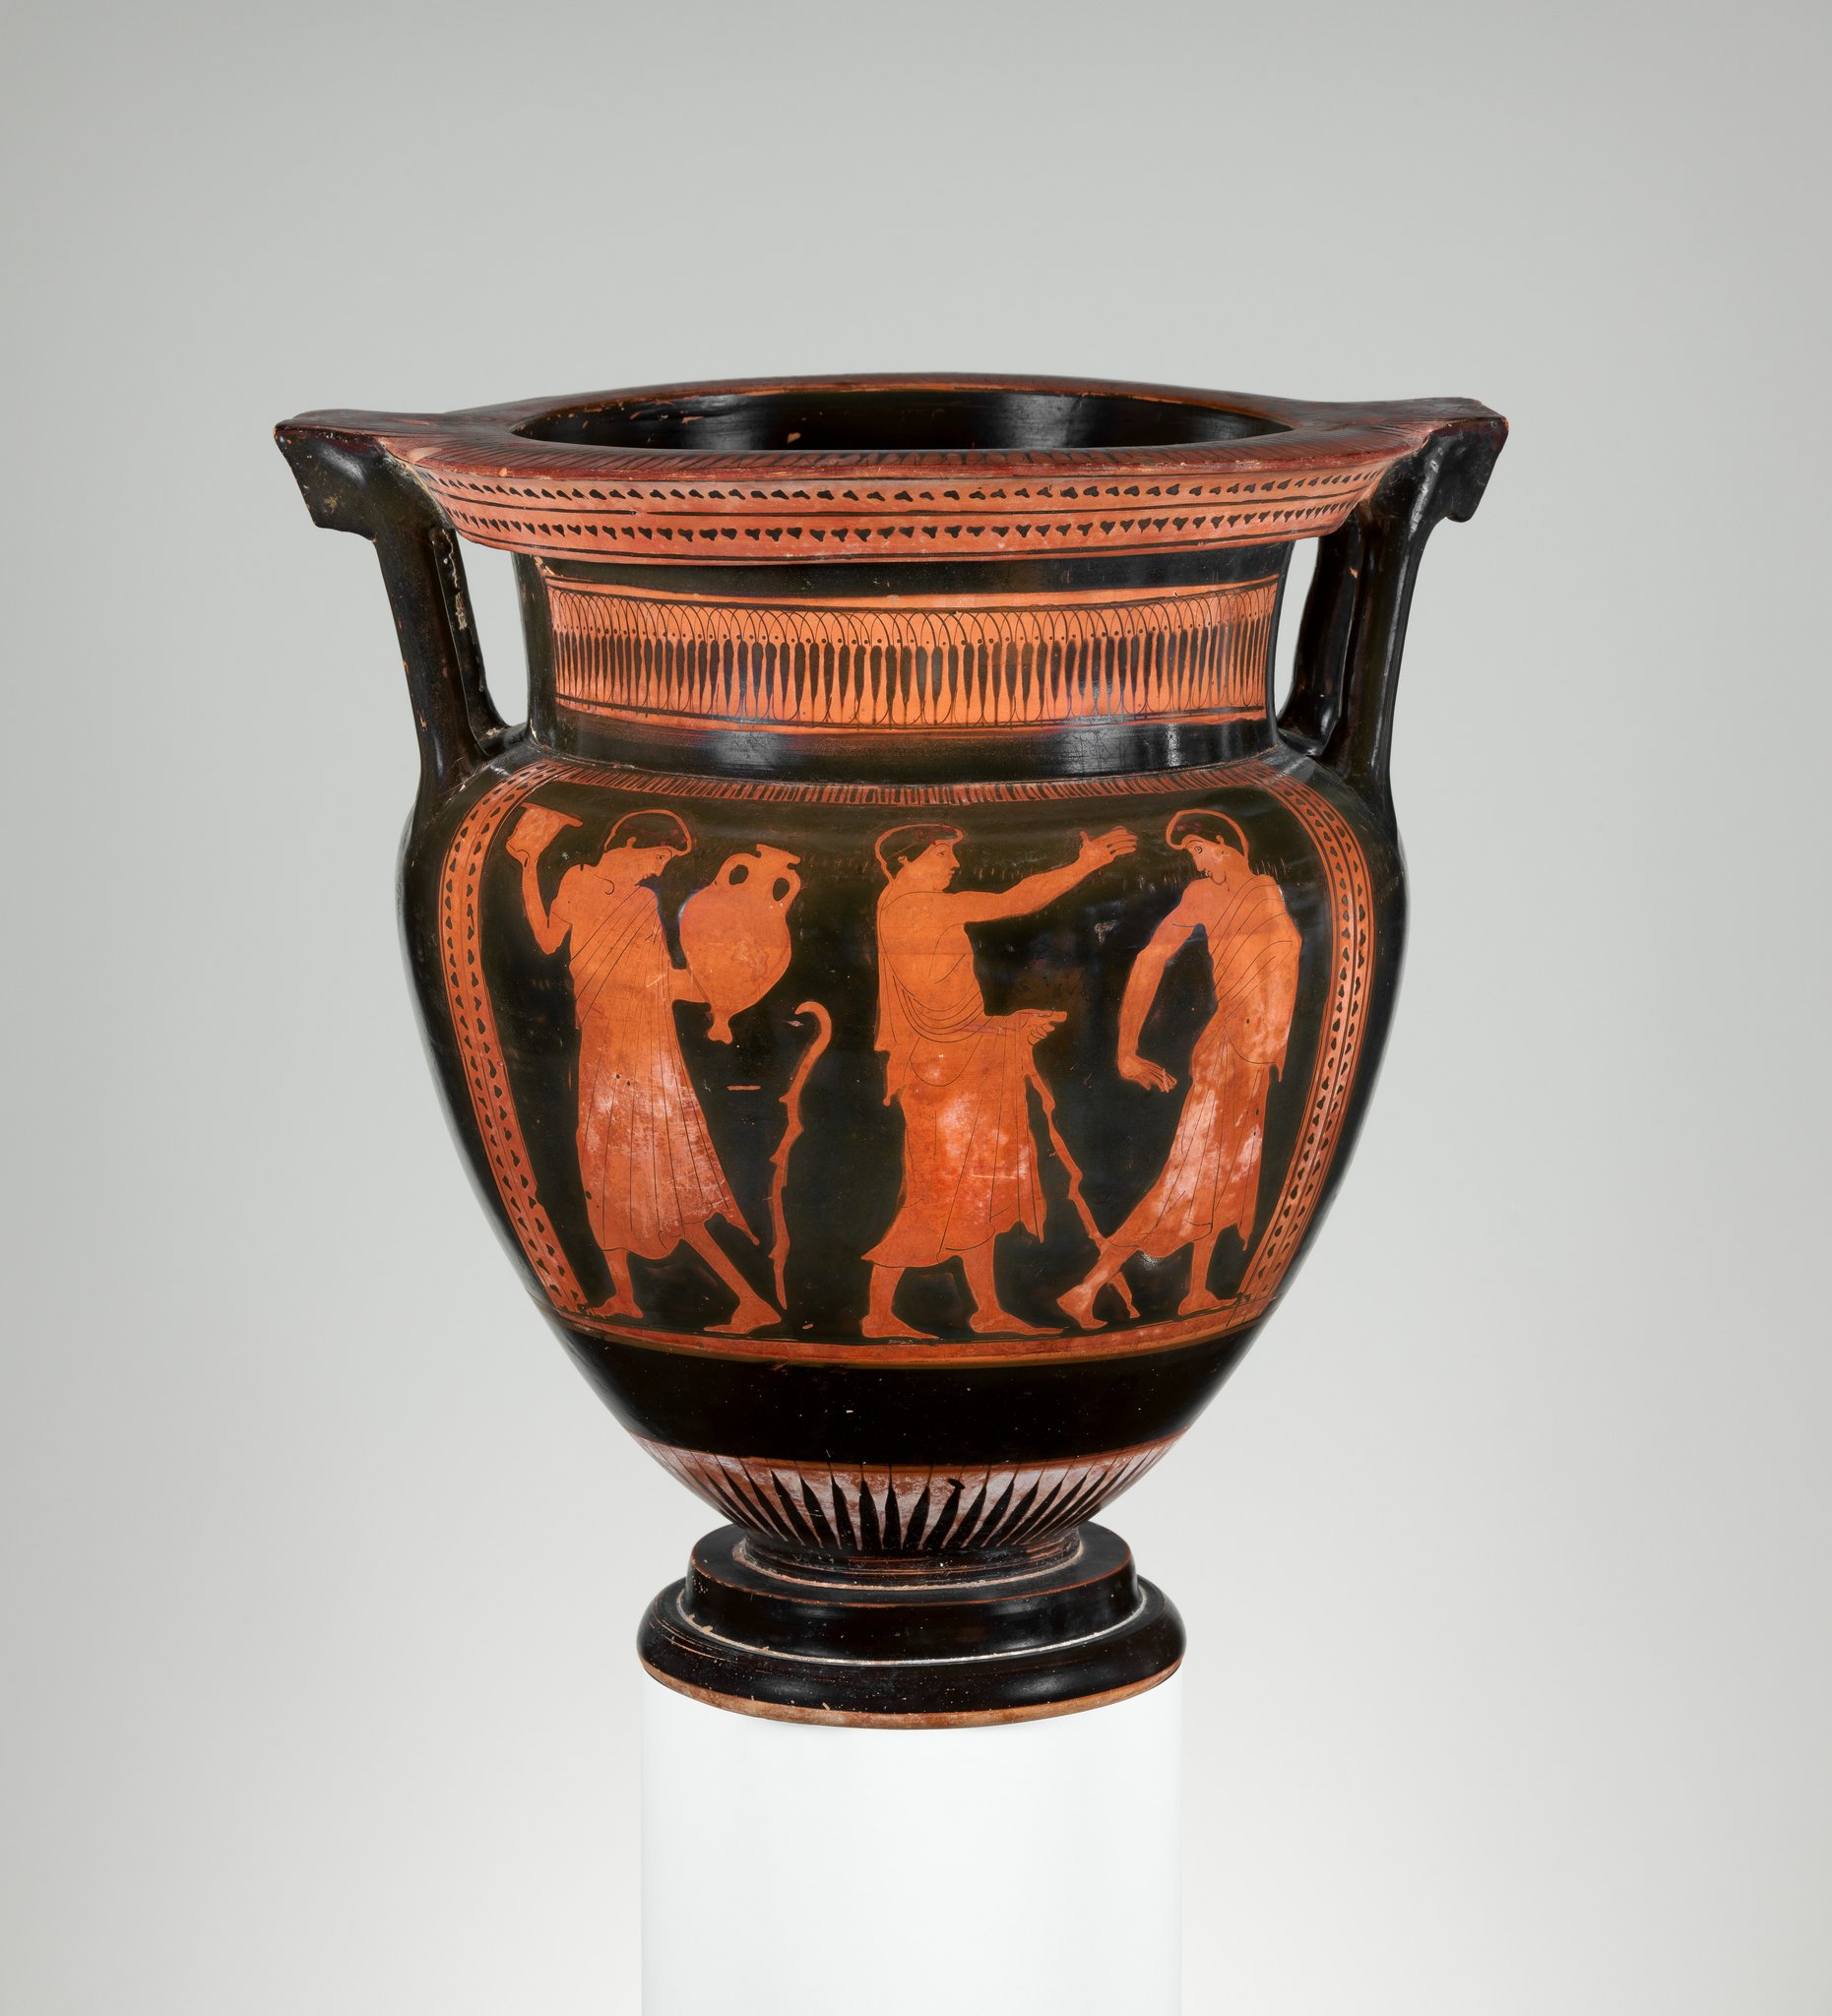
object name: column krater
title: Column-krater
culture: greek, attic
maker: leningrad painter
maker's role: artist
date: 475-465 BCE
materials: terracotta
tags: men,flutes,musicians